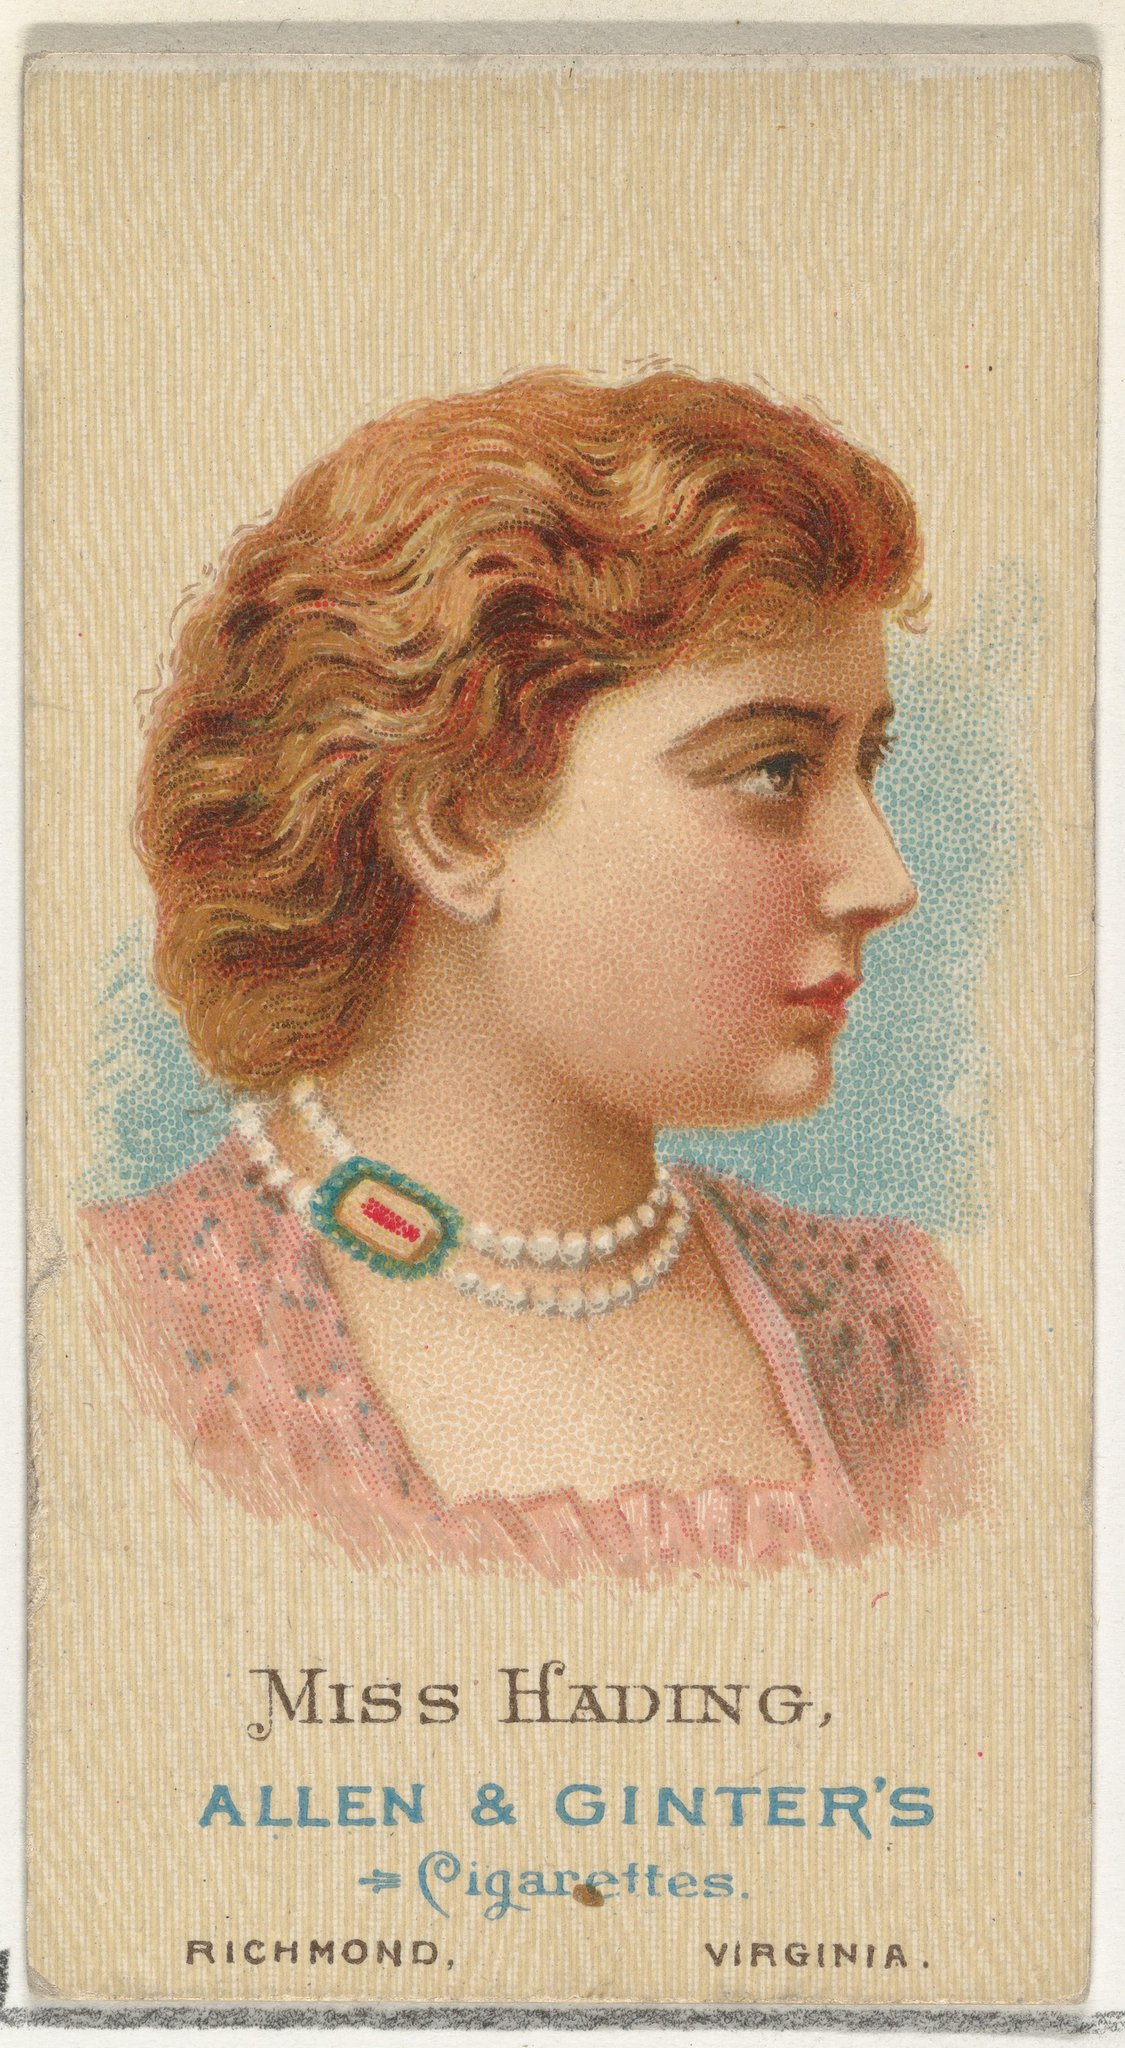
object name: print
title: Miss Hading, from World's Beauties, Series 2 (N27) for Allen & Ginter Cigarettes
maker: allen & ginter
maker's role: publisher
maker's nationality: american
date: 1888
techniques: color lithograph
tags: women